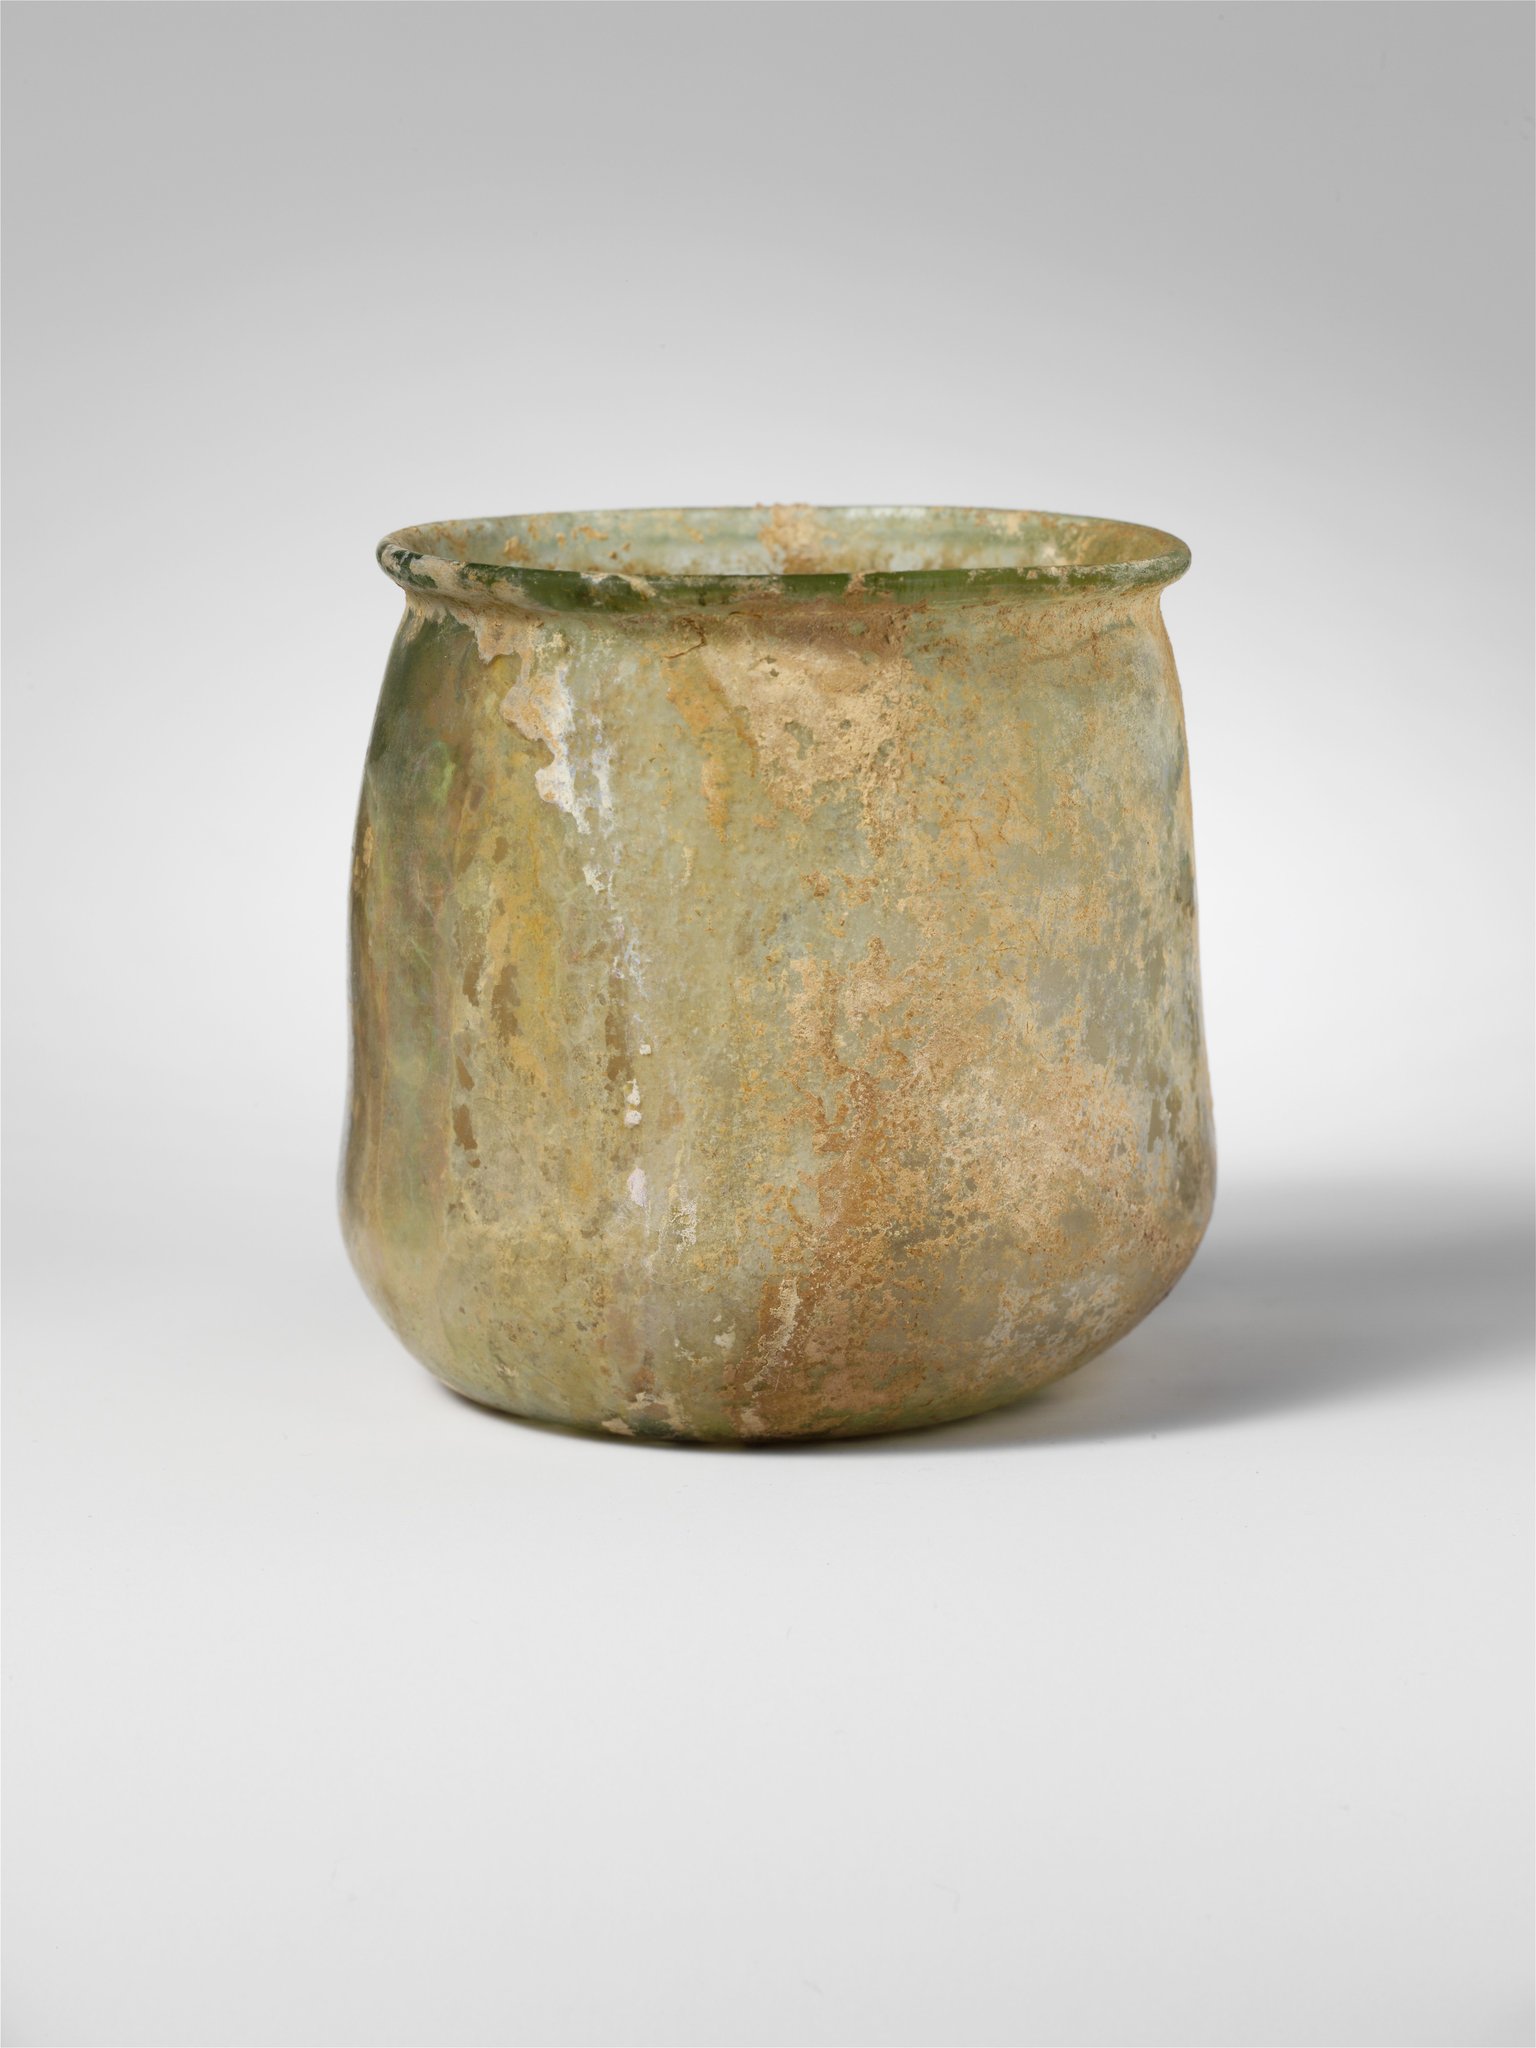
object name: cup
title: Glass cup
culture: roman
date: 101-300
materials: glass